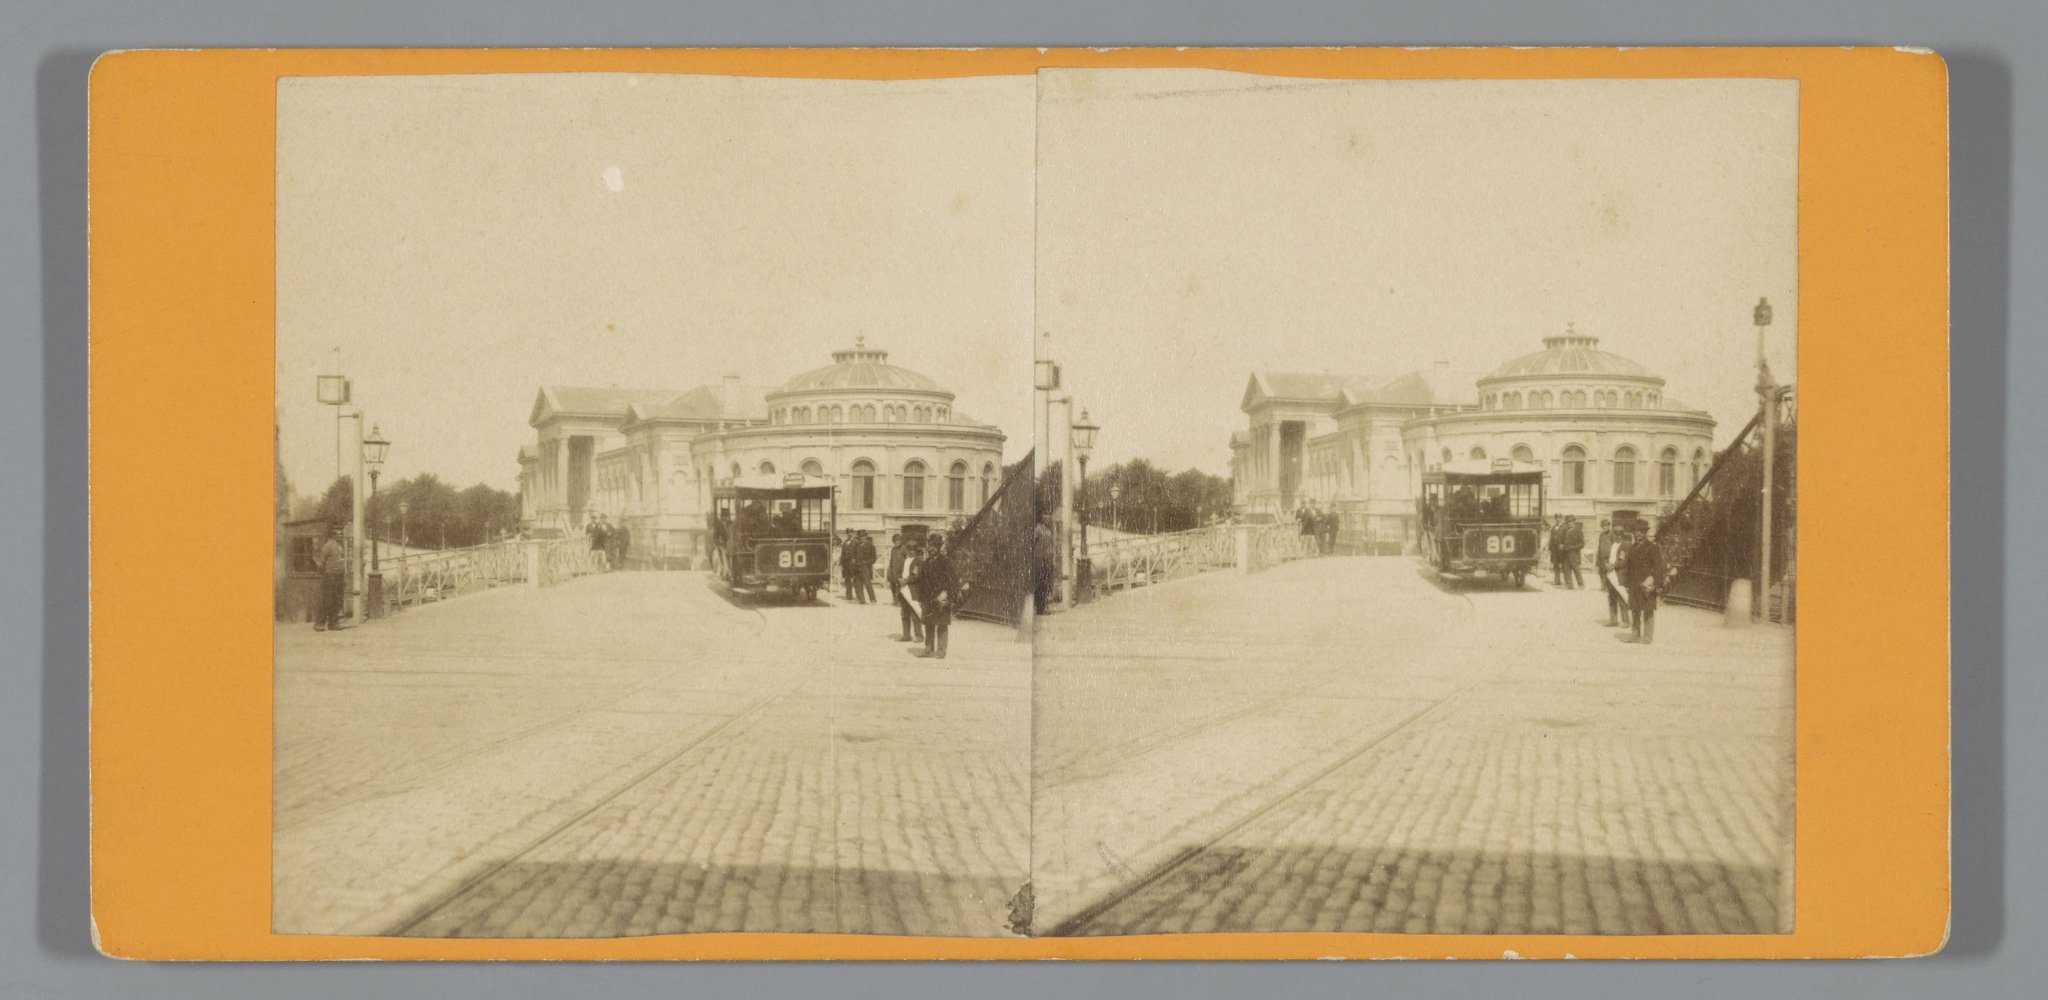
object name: stereograph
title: Aquarium van Artis aan de Plantage Middenlaan, gezien vanaf de brug over de Plantage Muidergracht, Amsterdam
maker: Anonymous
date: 1882-1890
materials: cardboard, paper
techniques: albumen print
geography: amsterdam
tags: aquarium, zoological garden, zoo, seen as place where non-domestic animals are kept, street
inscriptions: inscription: ‘va. 20’